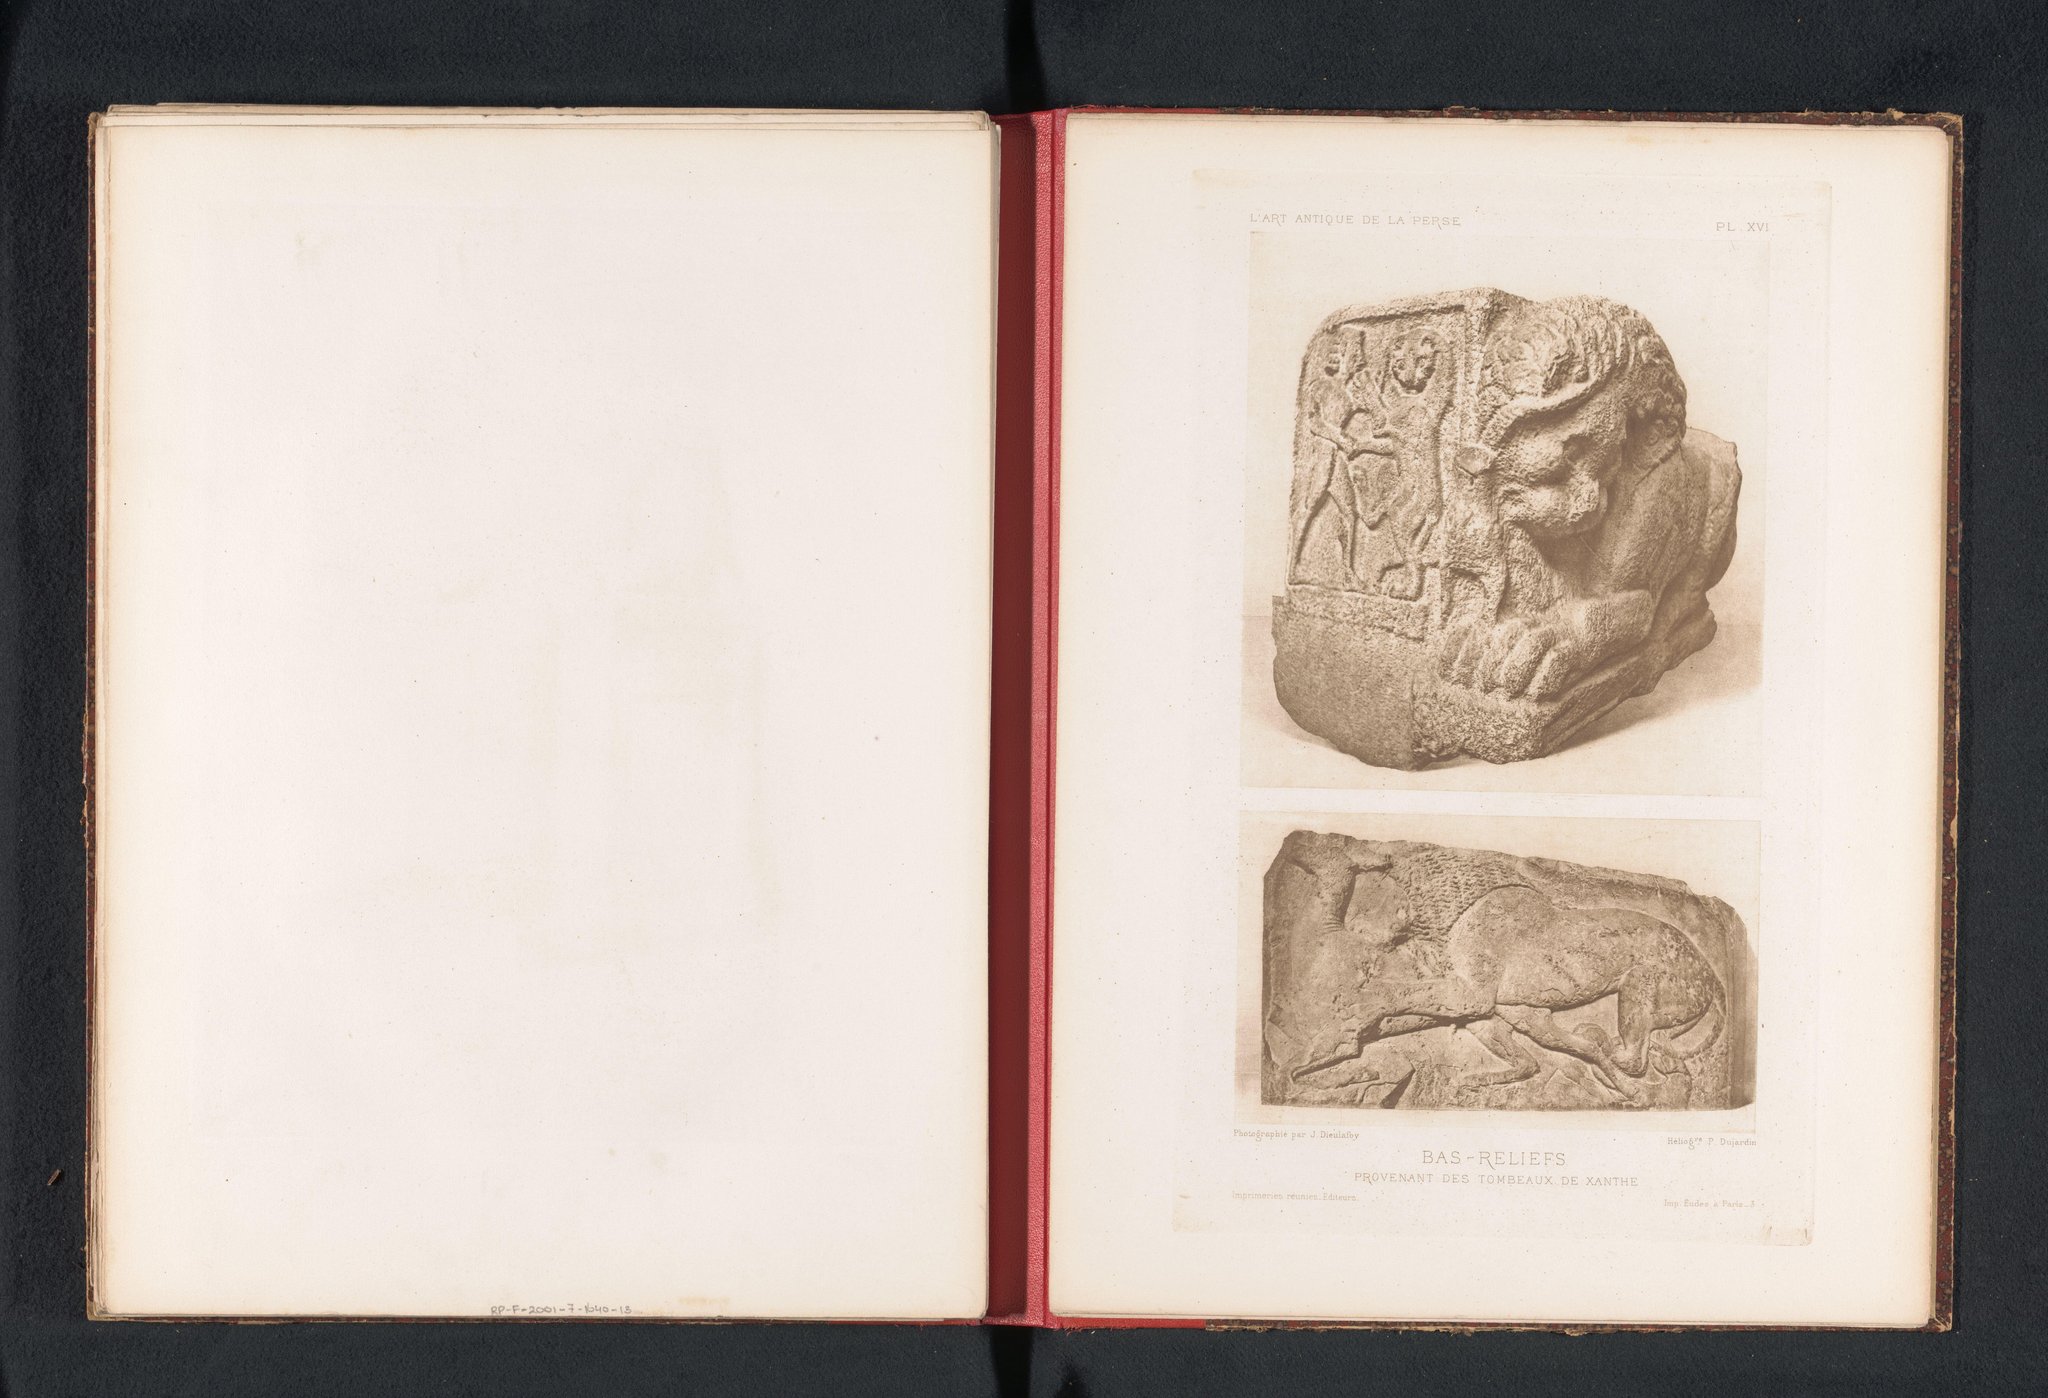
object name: photomechanical print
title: Bas-Reliefs Provenant des Tombeaux de Xanthe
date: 1880-1885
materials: paper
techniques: photoaquatint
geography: paris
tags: beasts of prey, predatory animals: lion, sculpture (+ relief ~ sculpture)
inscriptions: number: ‘PL. XVI’, inscription: ‘Imprimeries réunies_Editeurs. Imp. Eudes, à Paris_3.’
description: Deze prenten maken deel uit van een omslag met twintig prenten op zeventien bladen en vijftien tekstbladen.